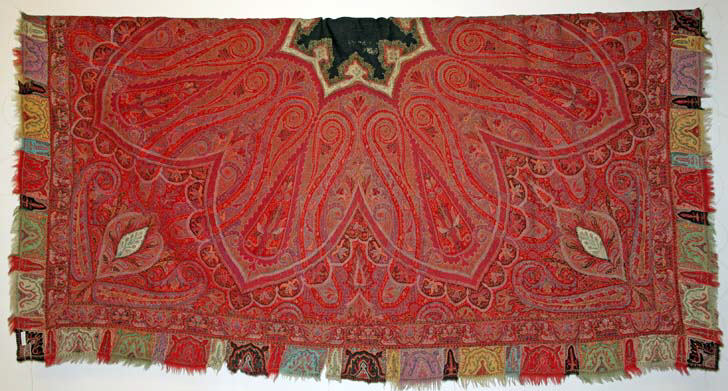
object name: shawl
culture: indian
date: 1870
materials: wool